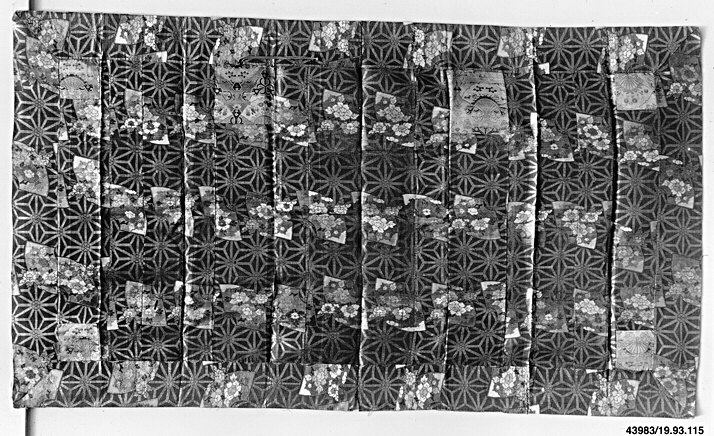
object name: robe, priest's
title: Priest's Robe (Shichijō)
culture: japanese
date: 1648-1652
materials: silk